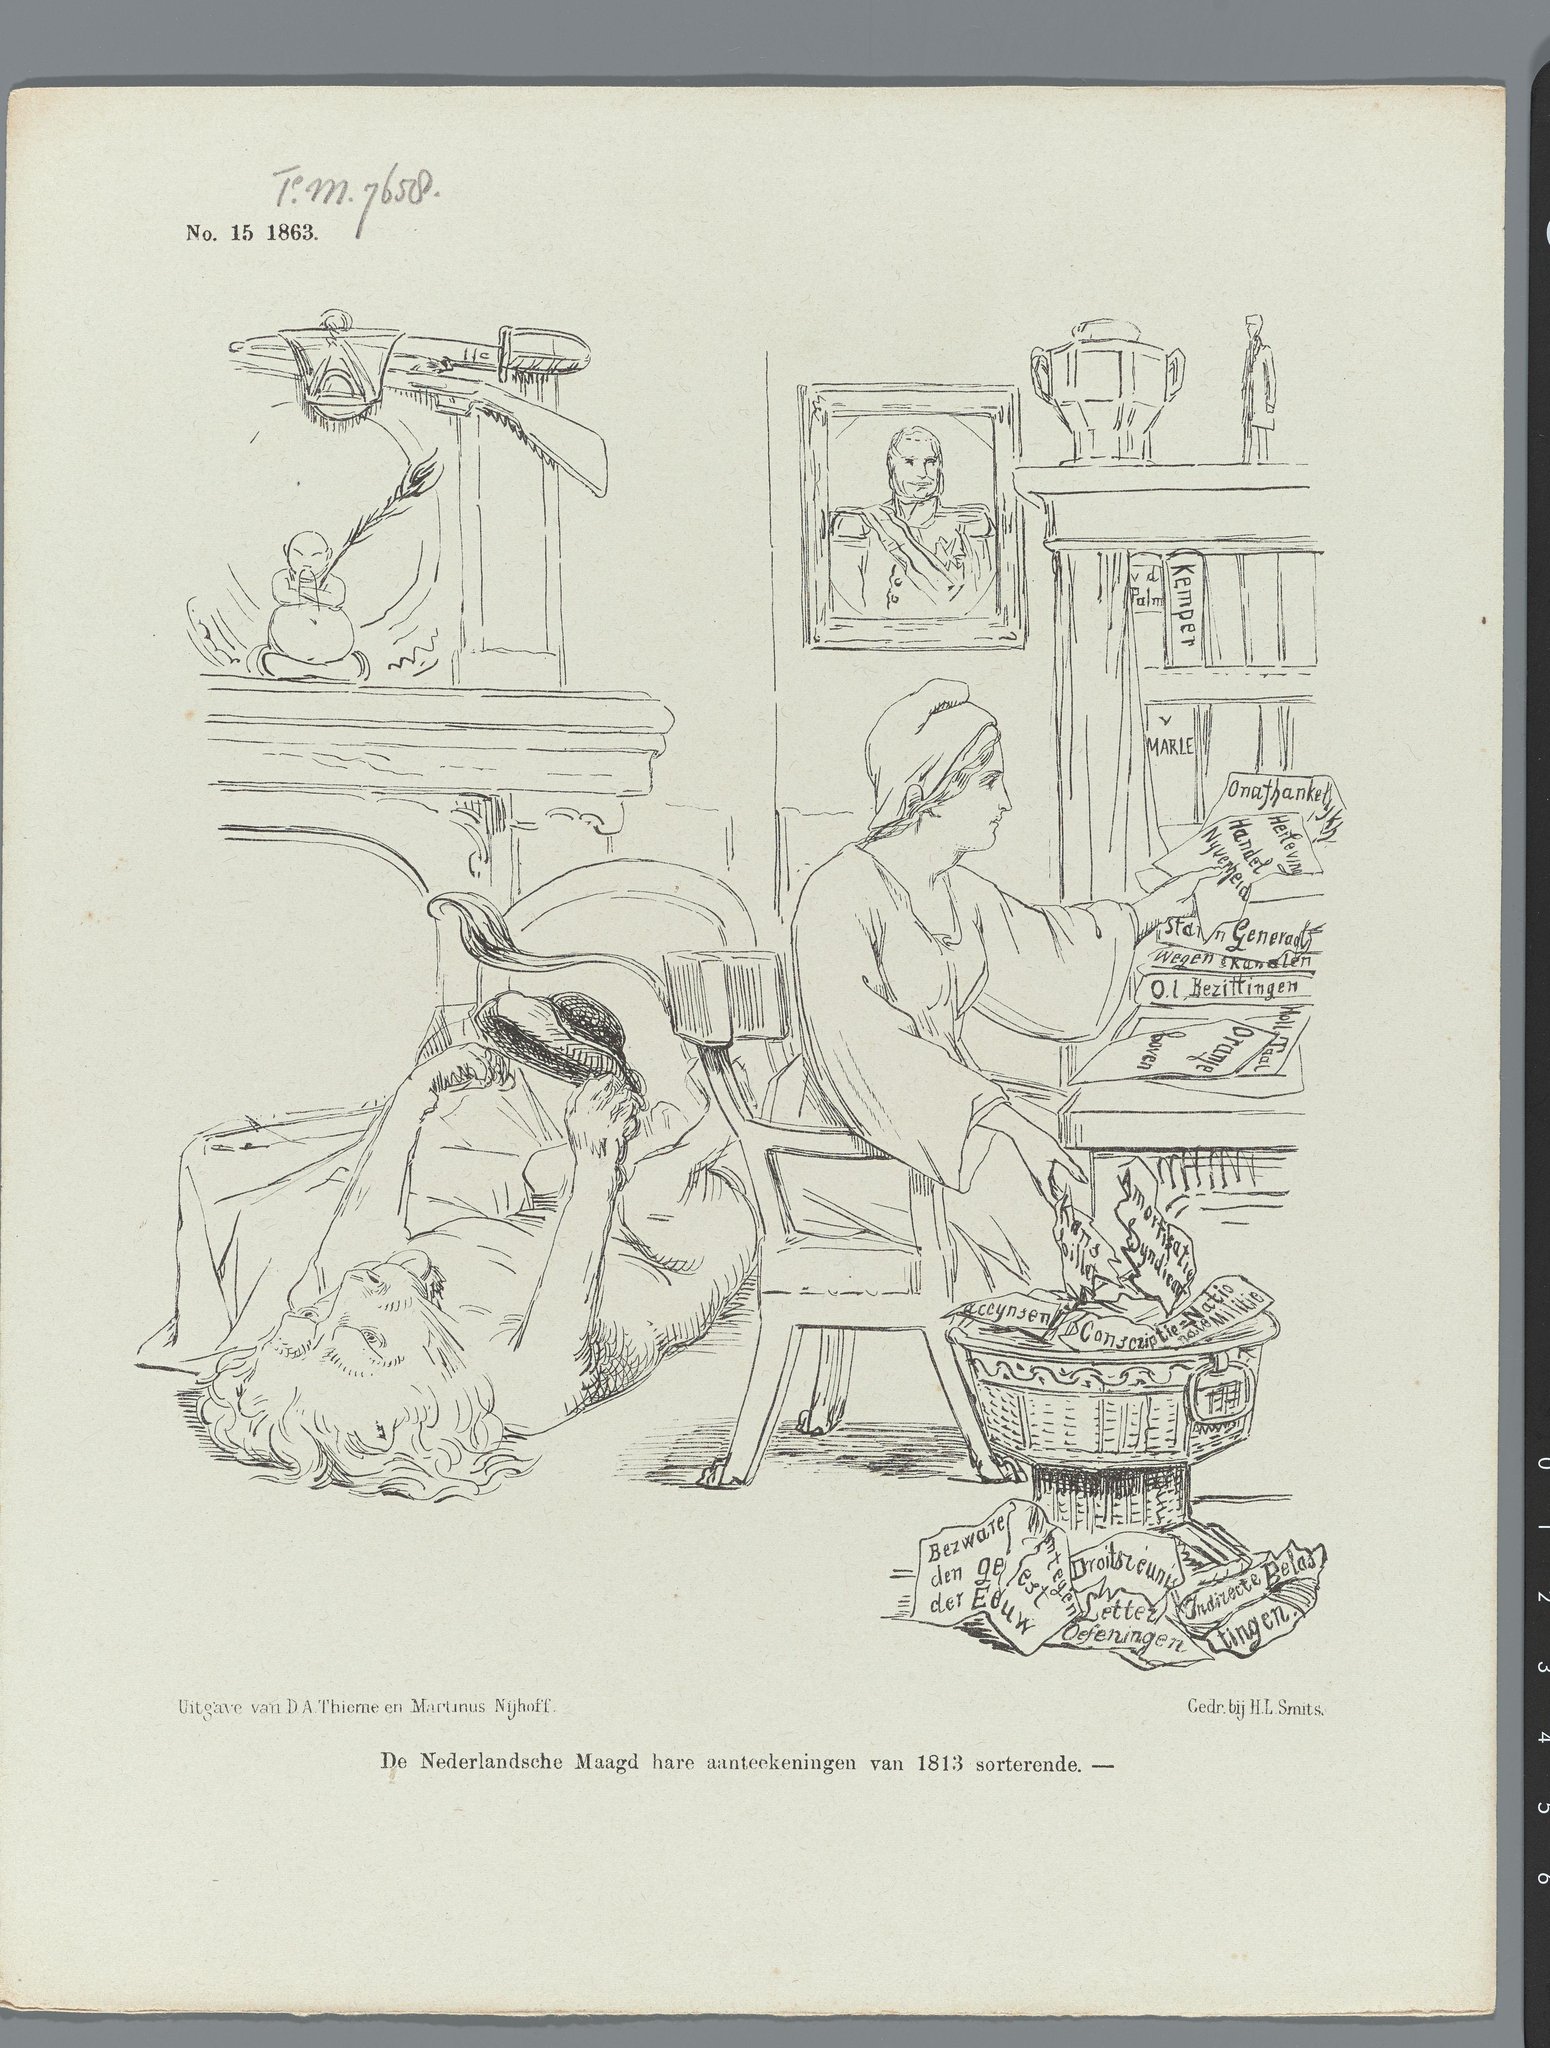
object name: print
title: De Nederlandsche Maagd hare aanteekeningen van 1813 sorterende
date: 1863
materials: paper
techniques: lithograph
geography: arnhem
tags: personifications of countries, nations, states, districts, etc., office (~ administration)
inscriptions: collector's mark: Lugt 2228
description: Spotprent op de aanstaande novemberfeesten. De Nederlandse Maagd zittend achter haar bureau sorteert haar papieren. Op de vloer speelt de Nederlandse Leeuw met de vrijheidshoed. Plaat verschenen bij het weekblad De Nederlandsche Spectator, nr. 15, 11 april 1863.